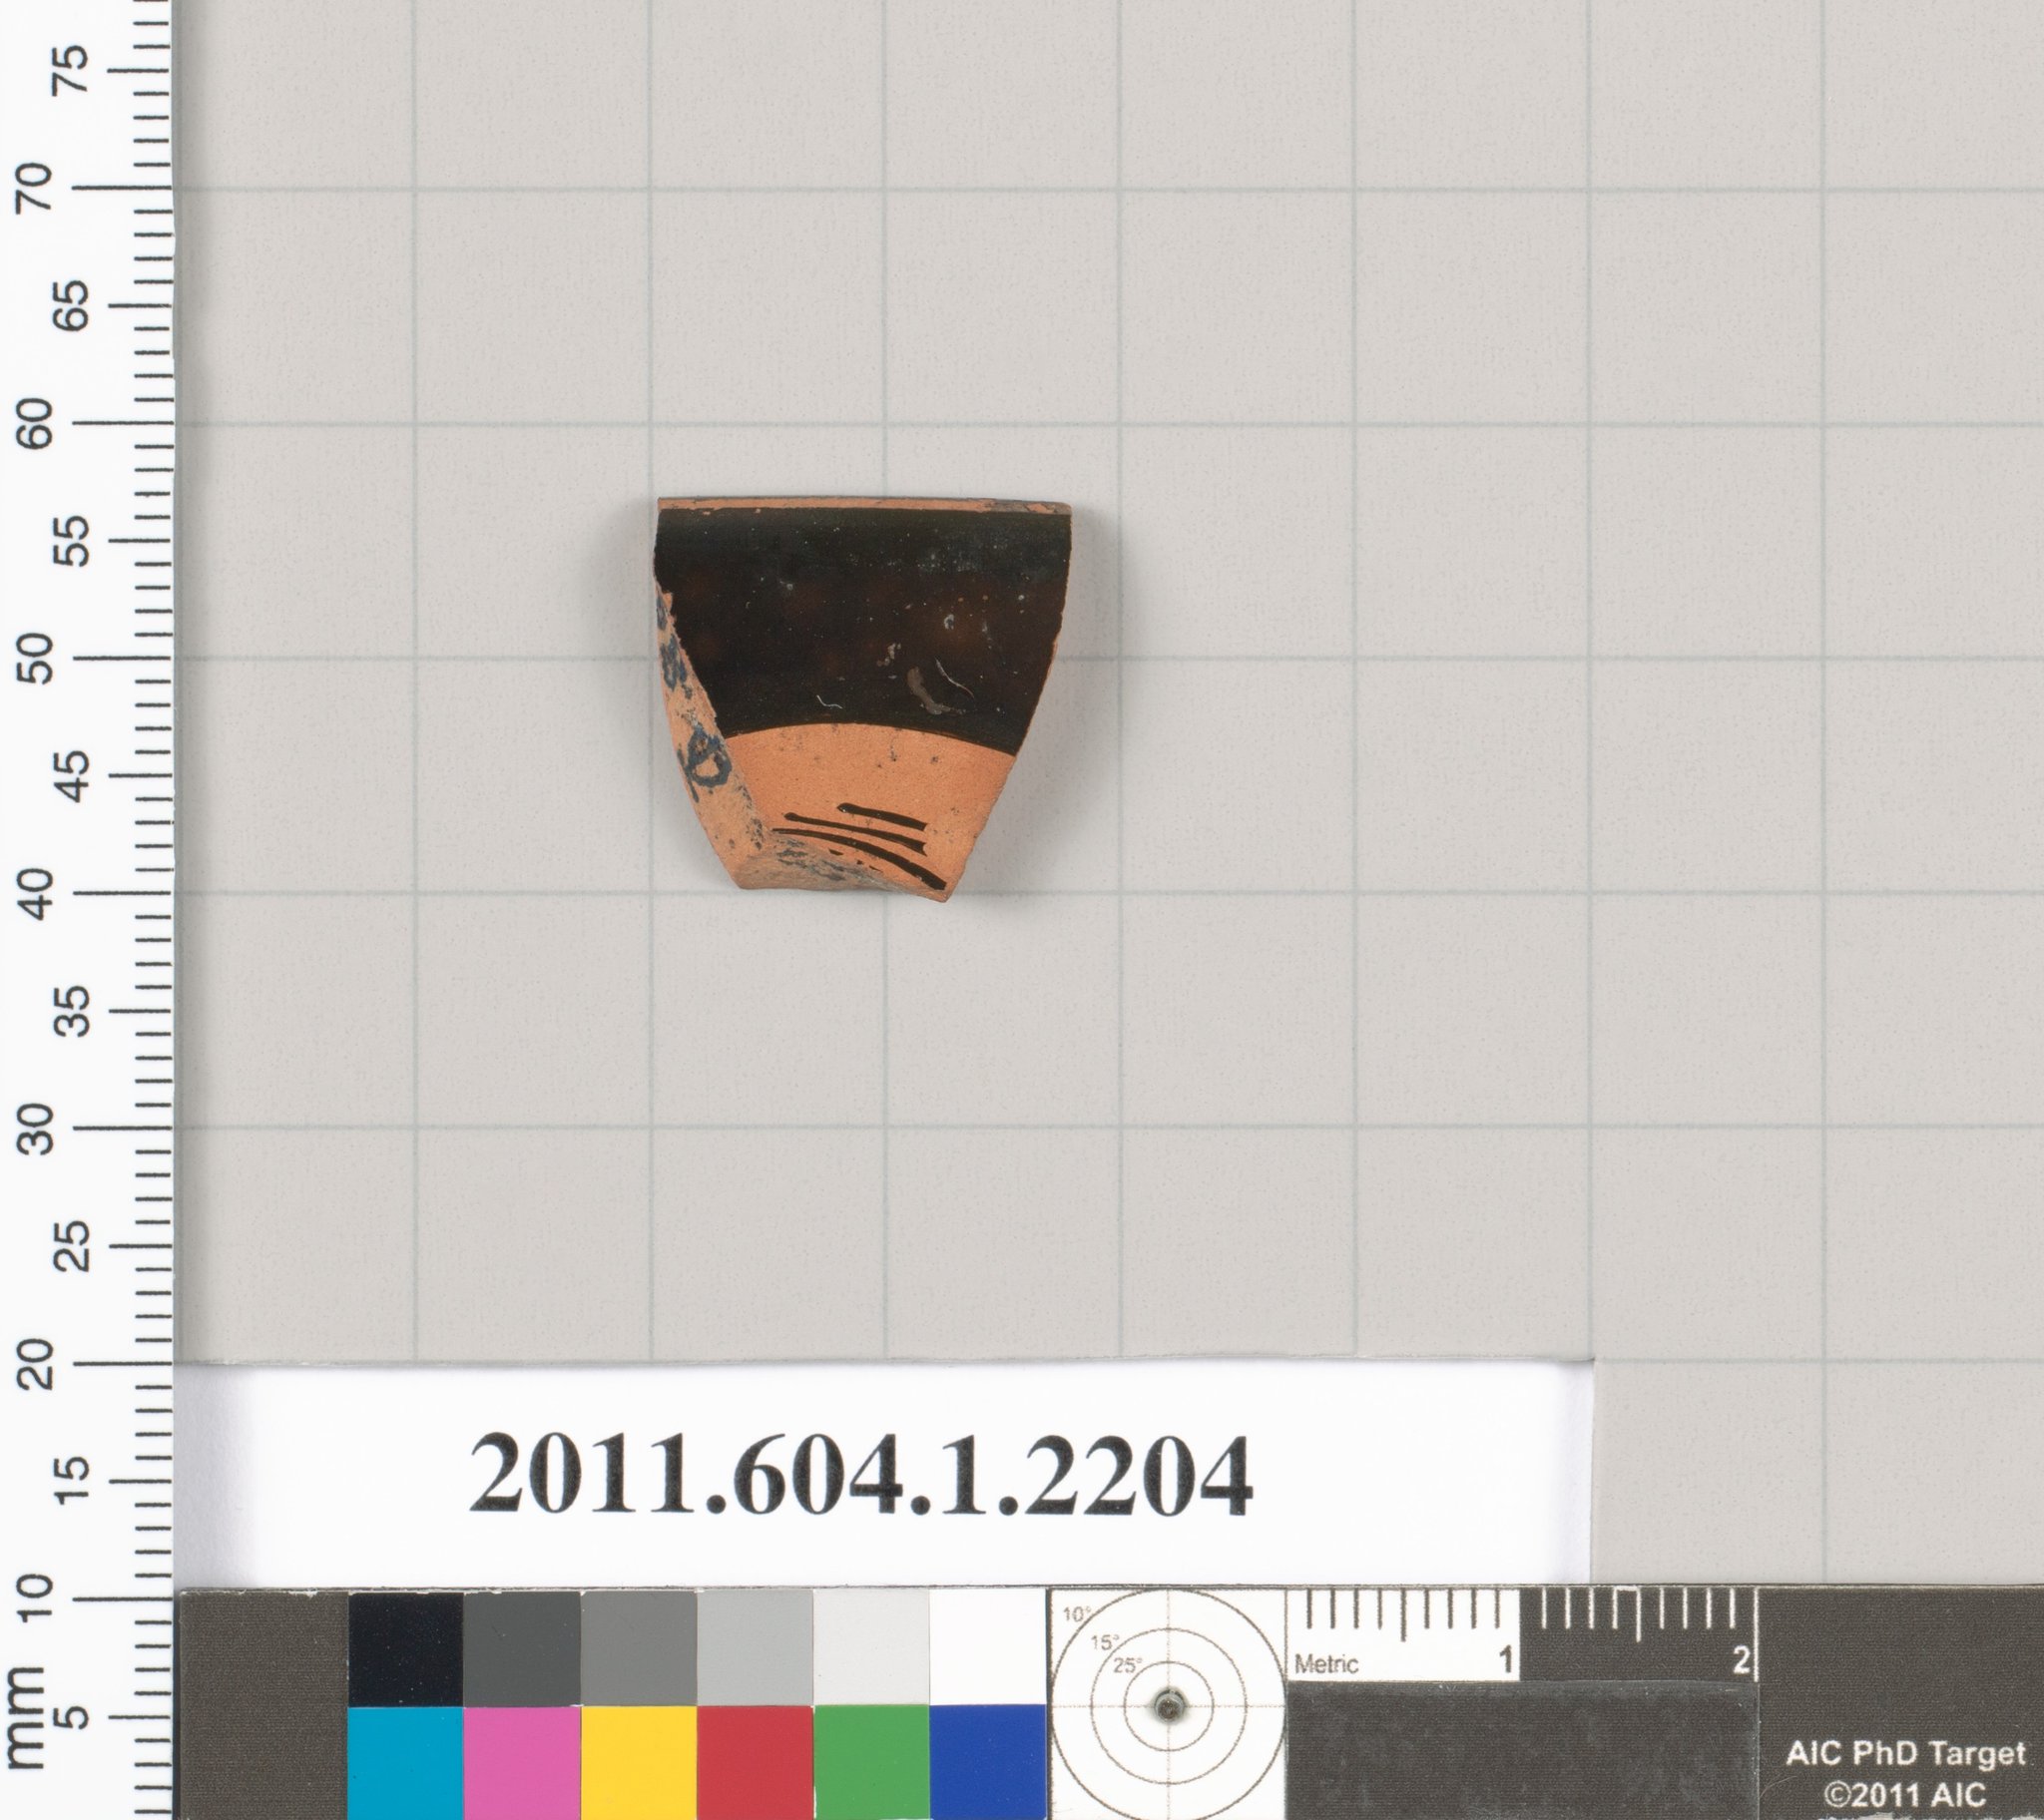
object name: kylix fragment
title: Terracotta rim fragment of a kylix (drinking cup)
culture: greek, attic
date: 490-480 BCE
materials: terracotta